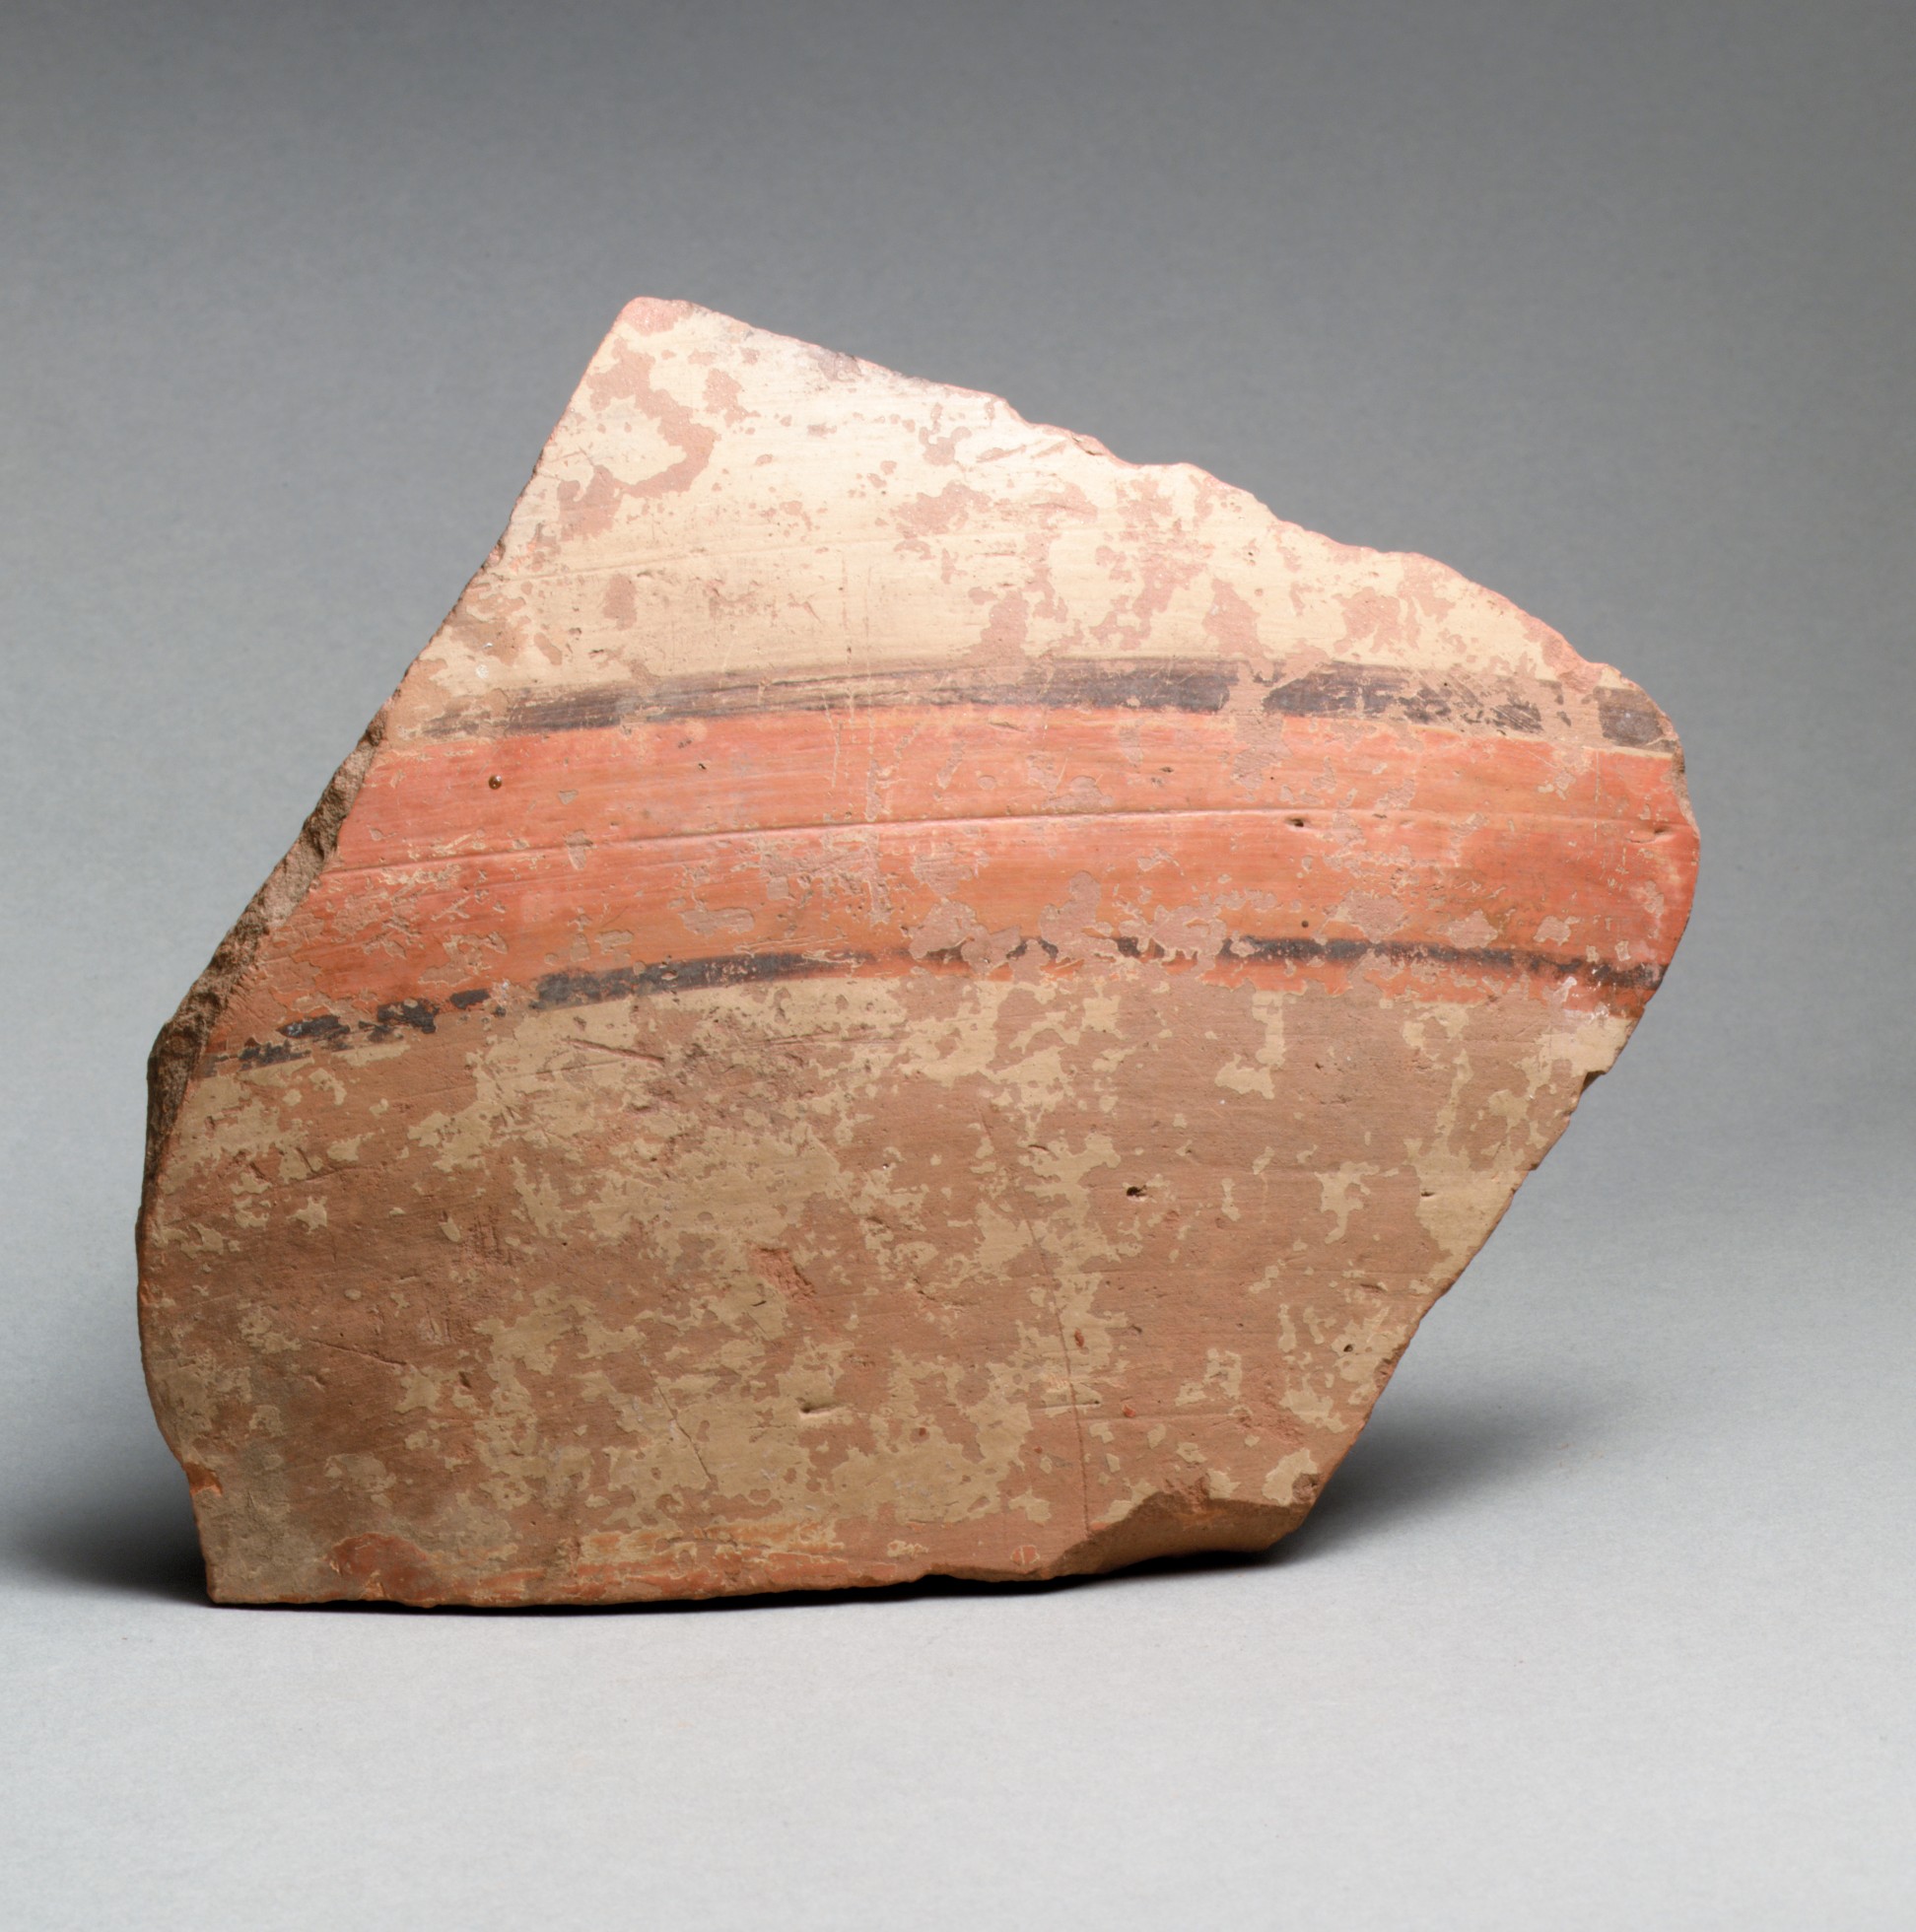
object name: vase fragment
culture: greek or lydian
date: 800-480 BCE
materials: terracotta